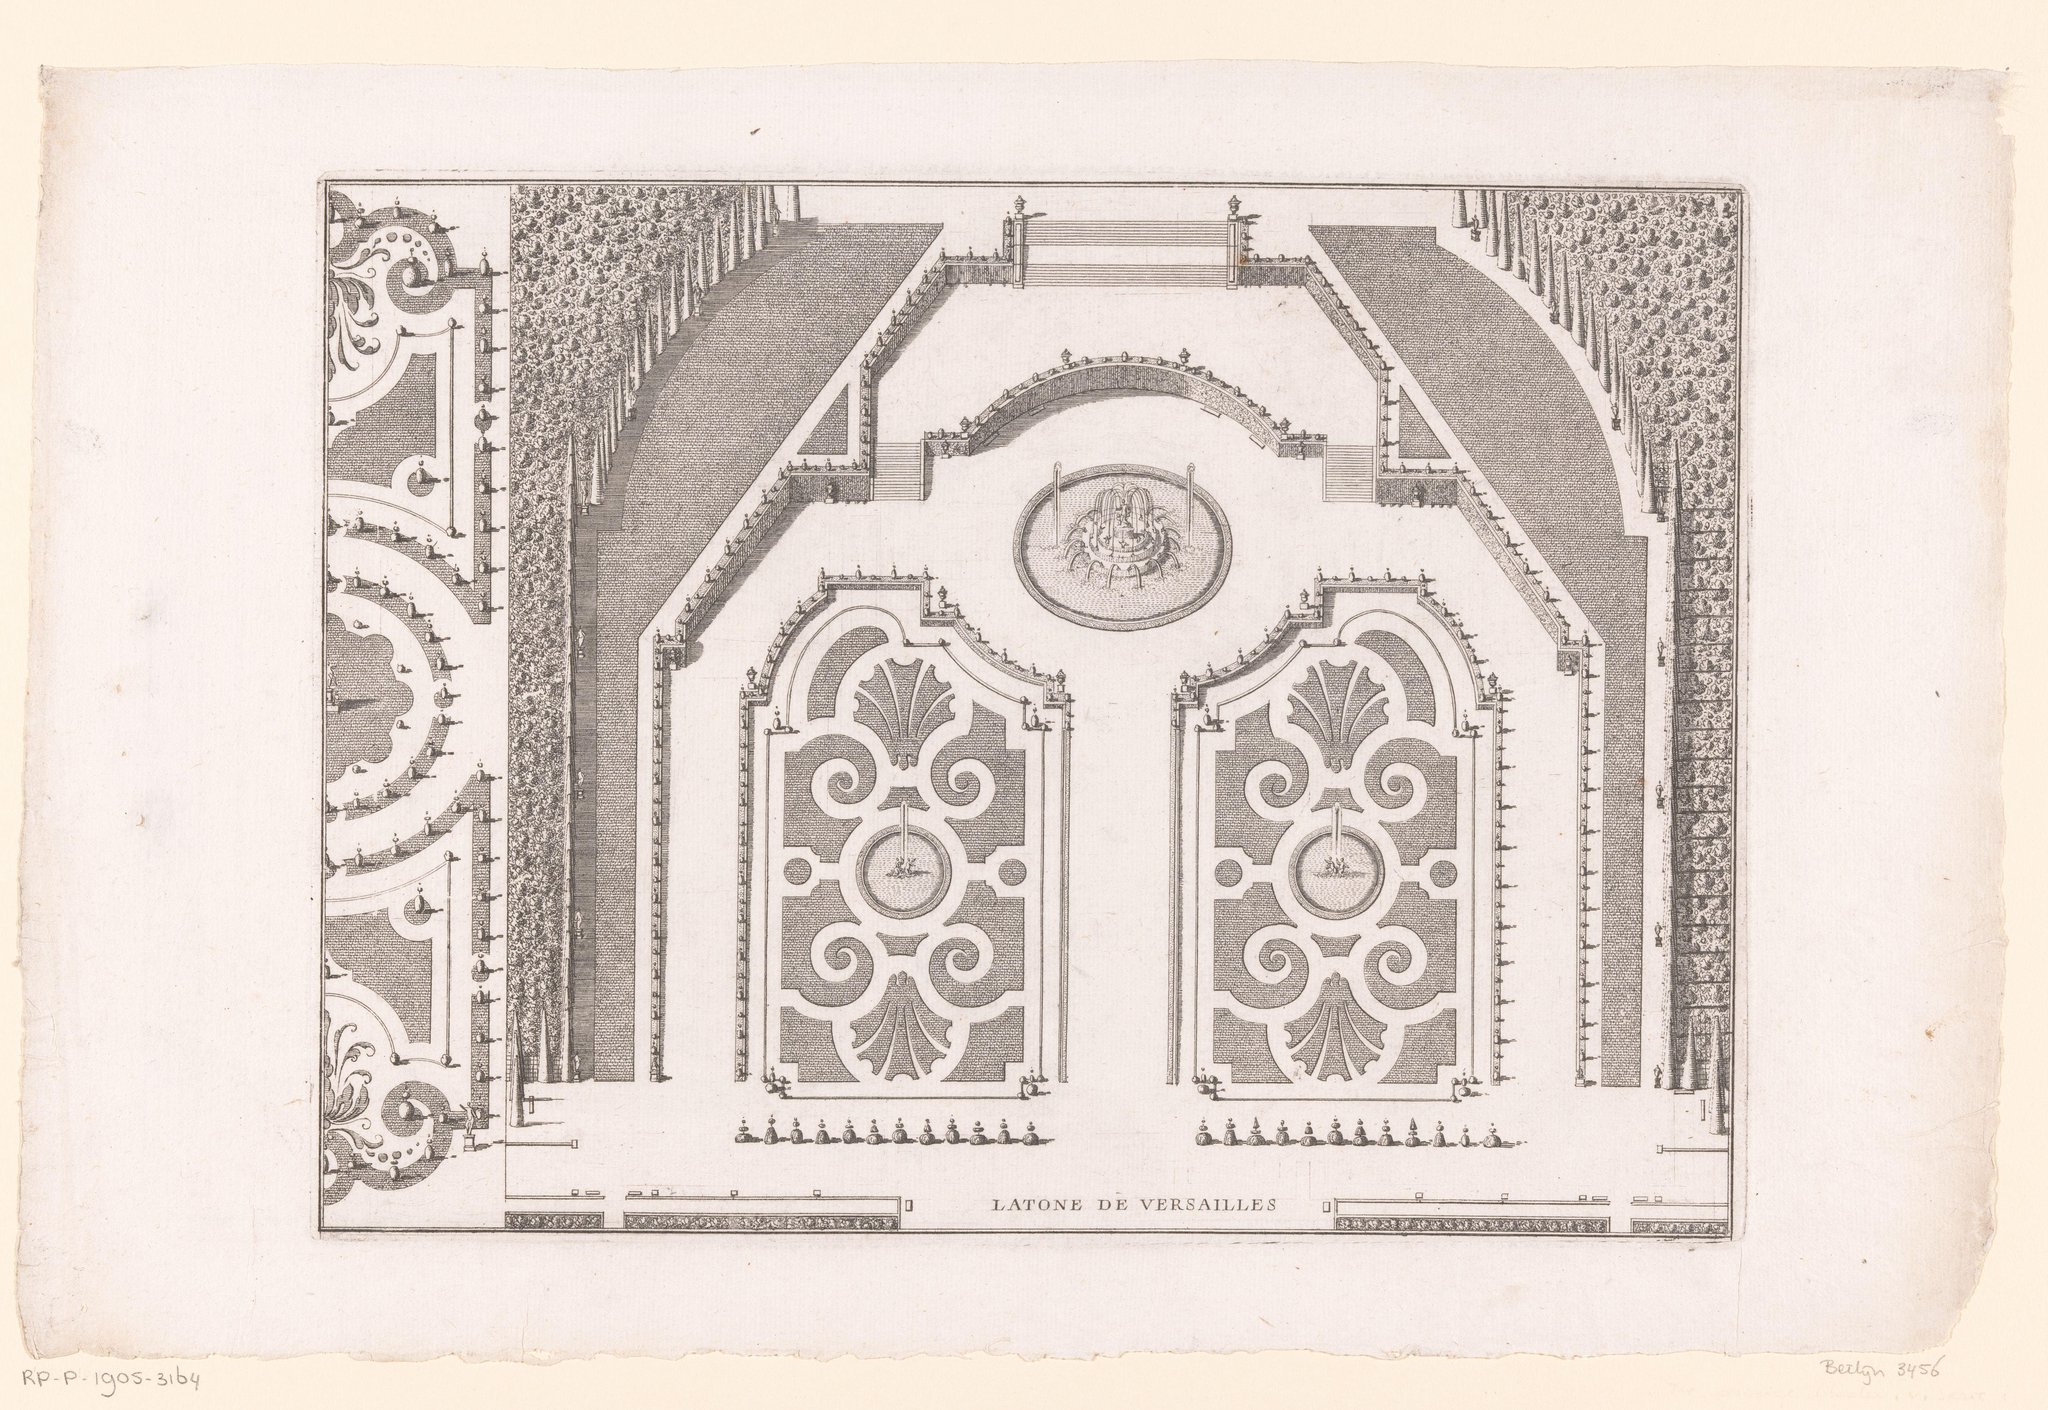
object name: ornament print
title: Latone De Versailles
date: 1650-1700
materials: paper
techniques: etching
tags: plan, map of garden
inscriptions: collector's mark: Lugt 2228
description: Twee parterres met ronde fonteinen en daarboven de Latona-fontein. rondom bomenlanen en perken met bomen. Links parterres met sculpturen.